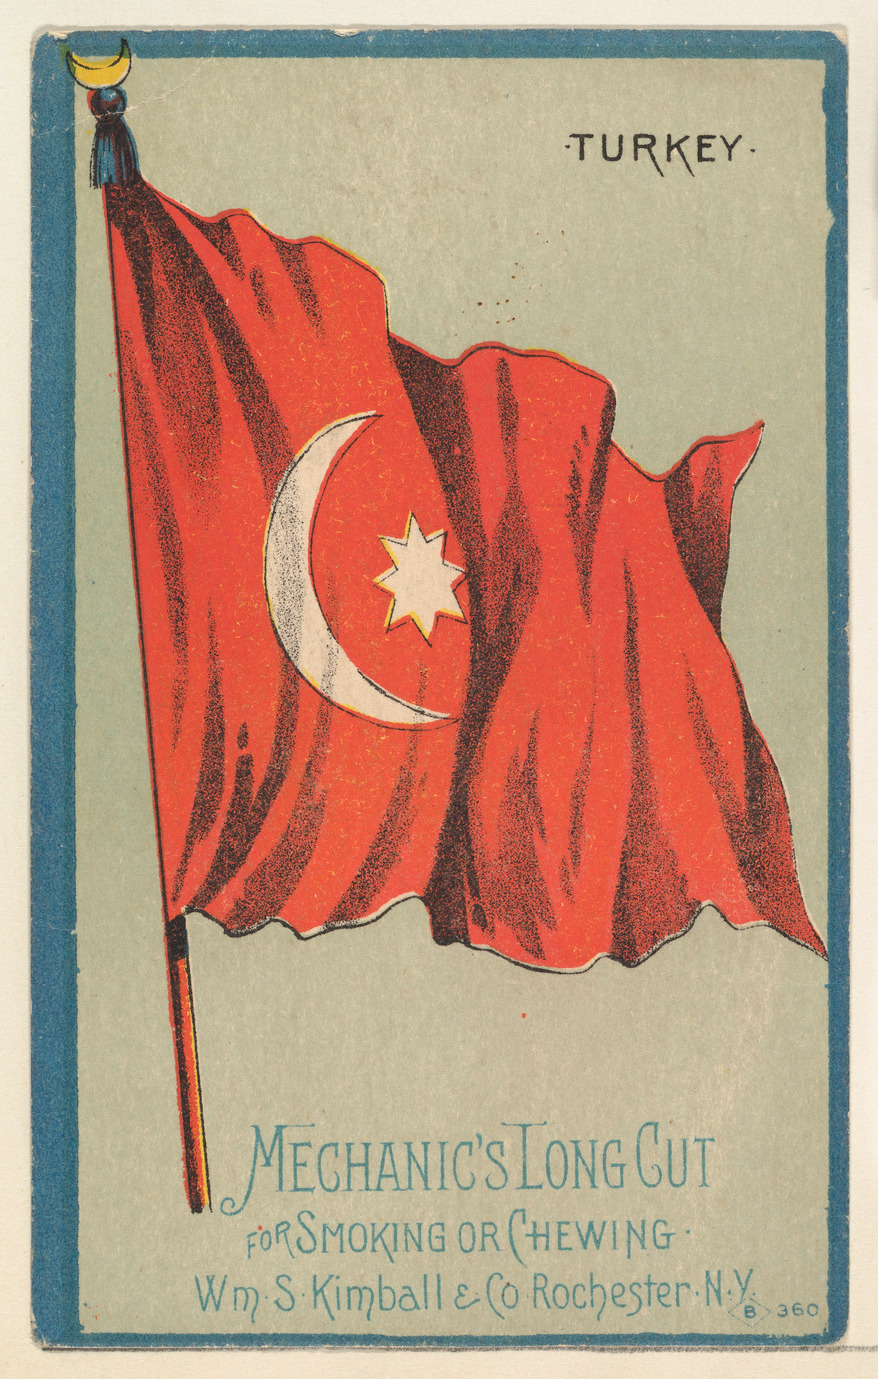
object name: print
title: Turkey, from the National Flags series (N195) issued by Wm. S. Kimball & Co.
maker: william s. kimball & company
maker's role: publisher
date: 1891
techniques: color lithograph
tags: flags